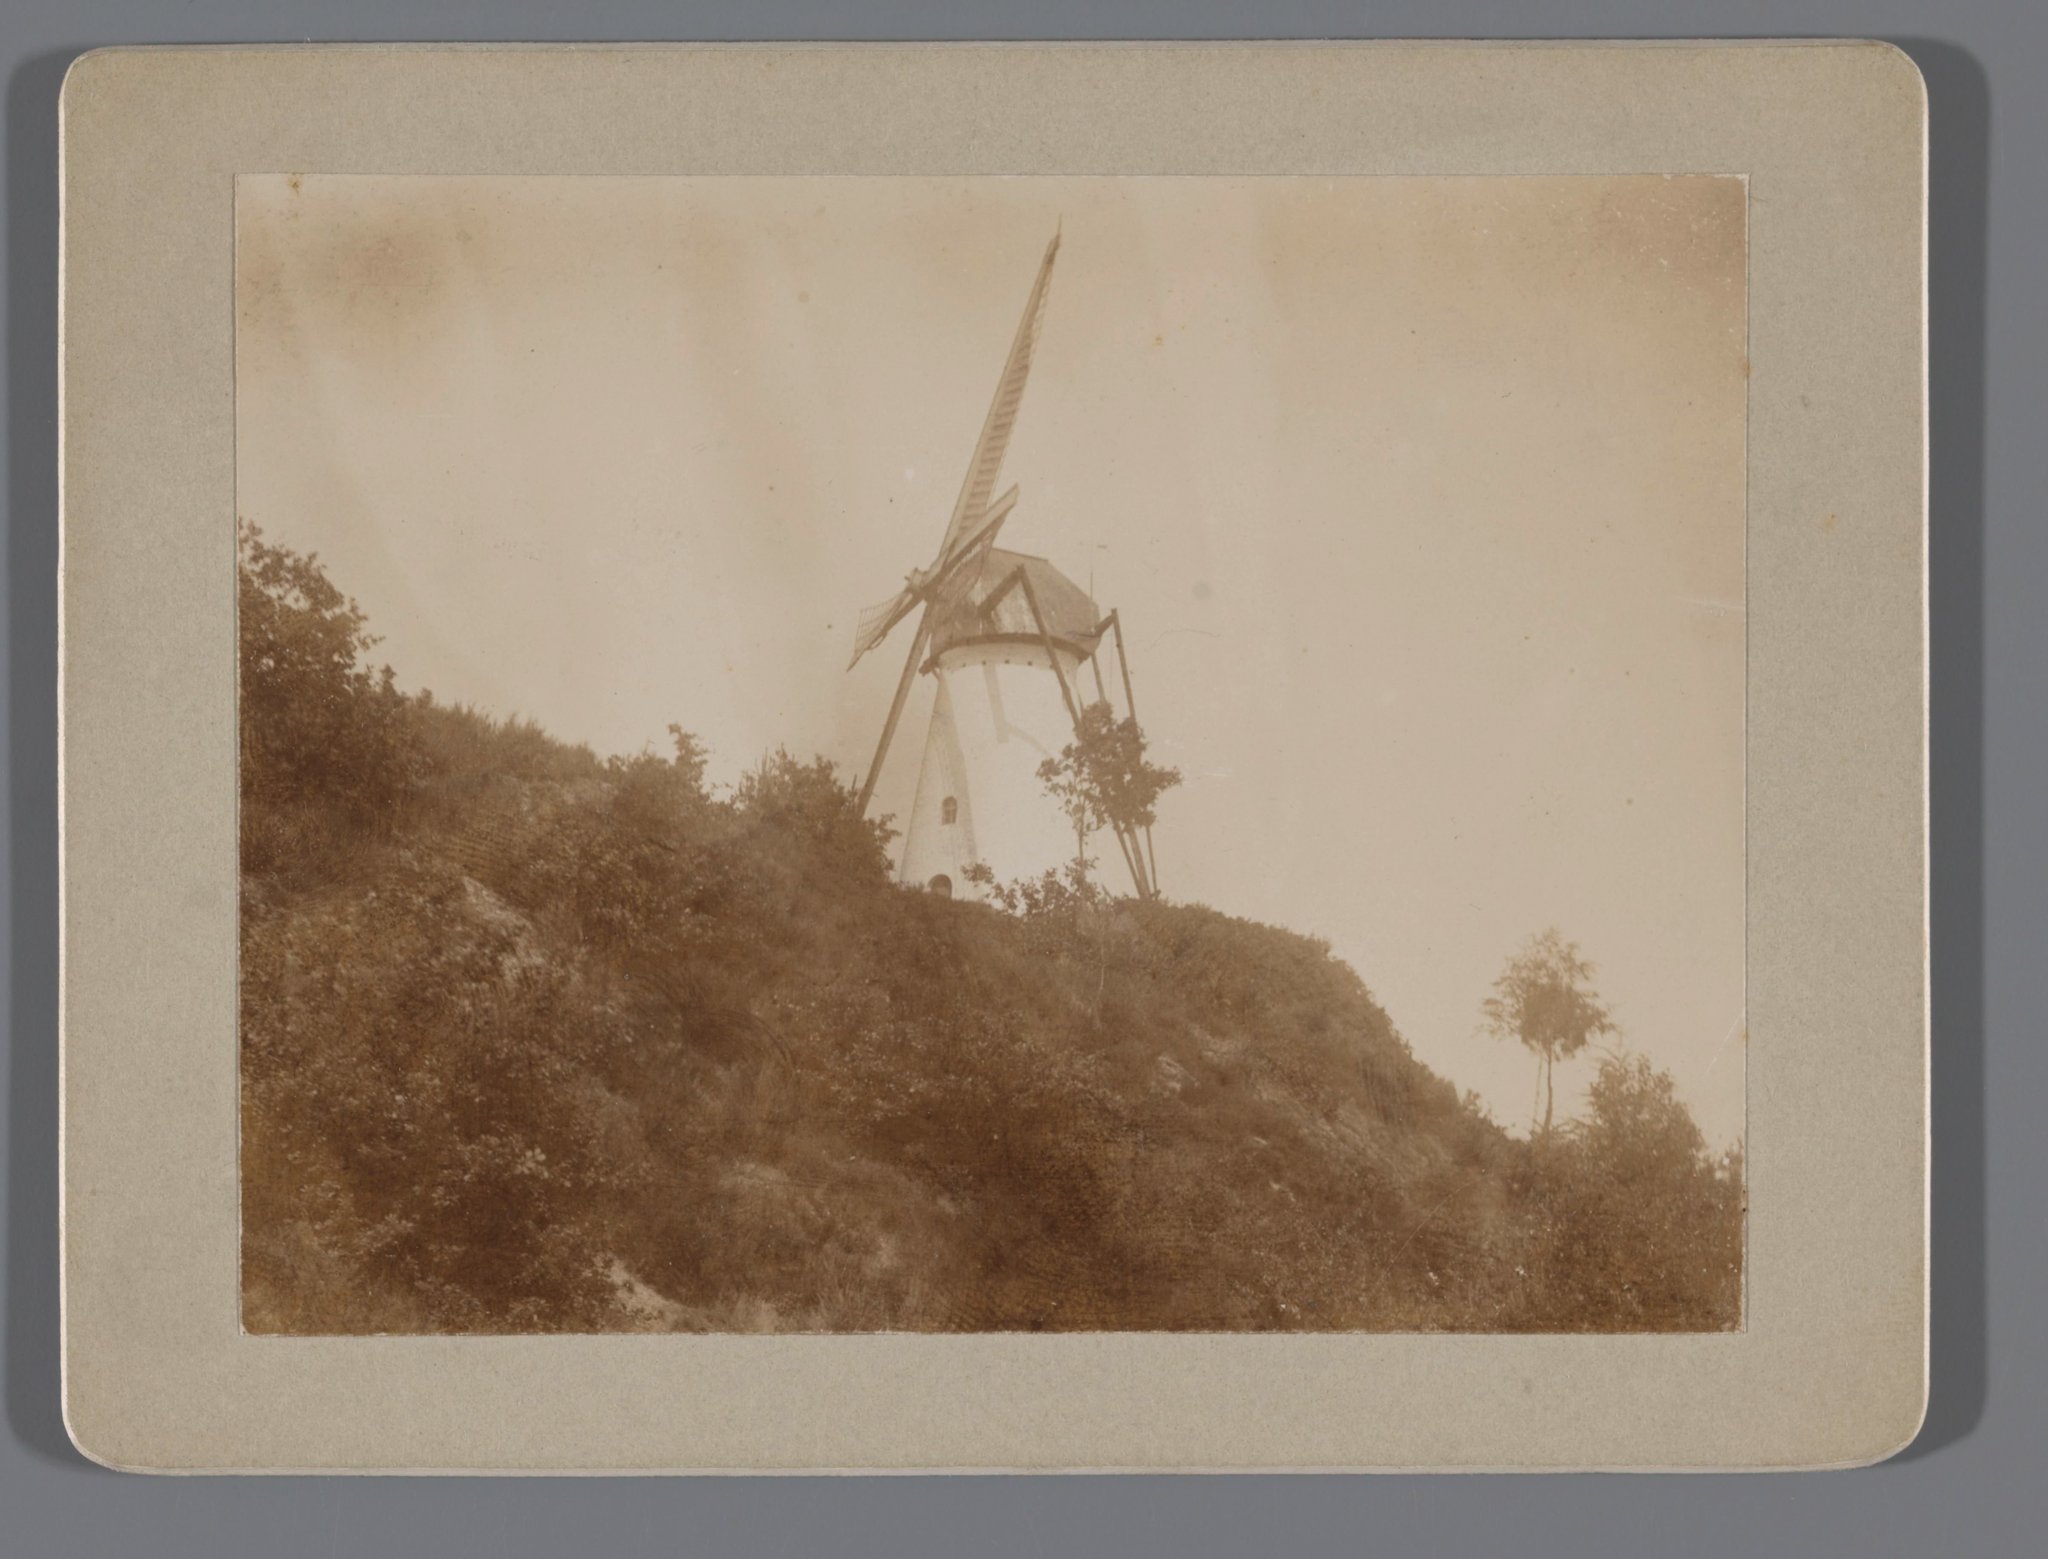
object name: photograph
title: Windmolen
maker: cornelia hendrika jonker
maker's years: 1874-1924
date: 1898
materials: cardboard, photographic support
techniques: collodion silver print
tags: windmill in landscape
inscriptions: annotation: ‘J.D. van der Waals/ 1898’